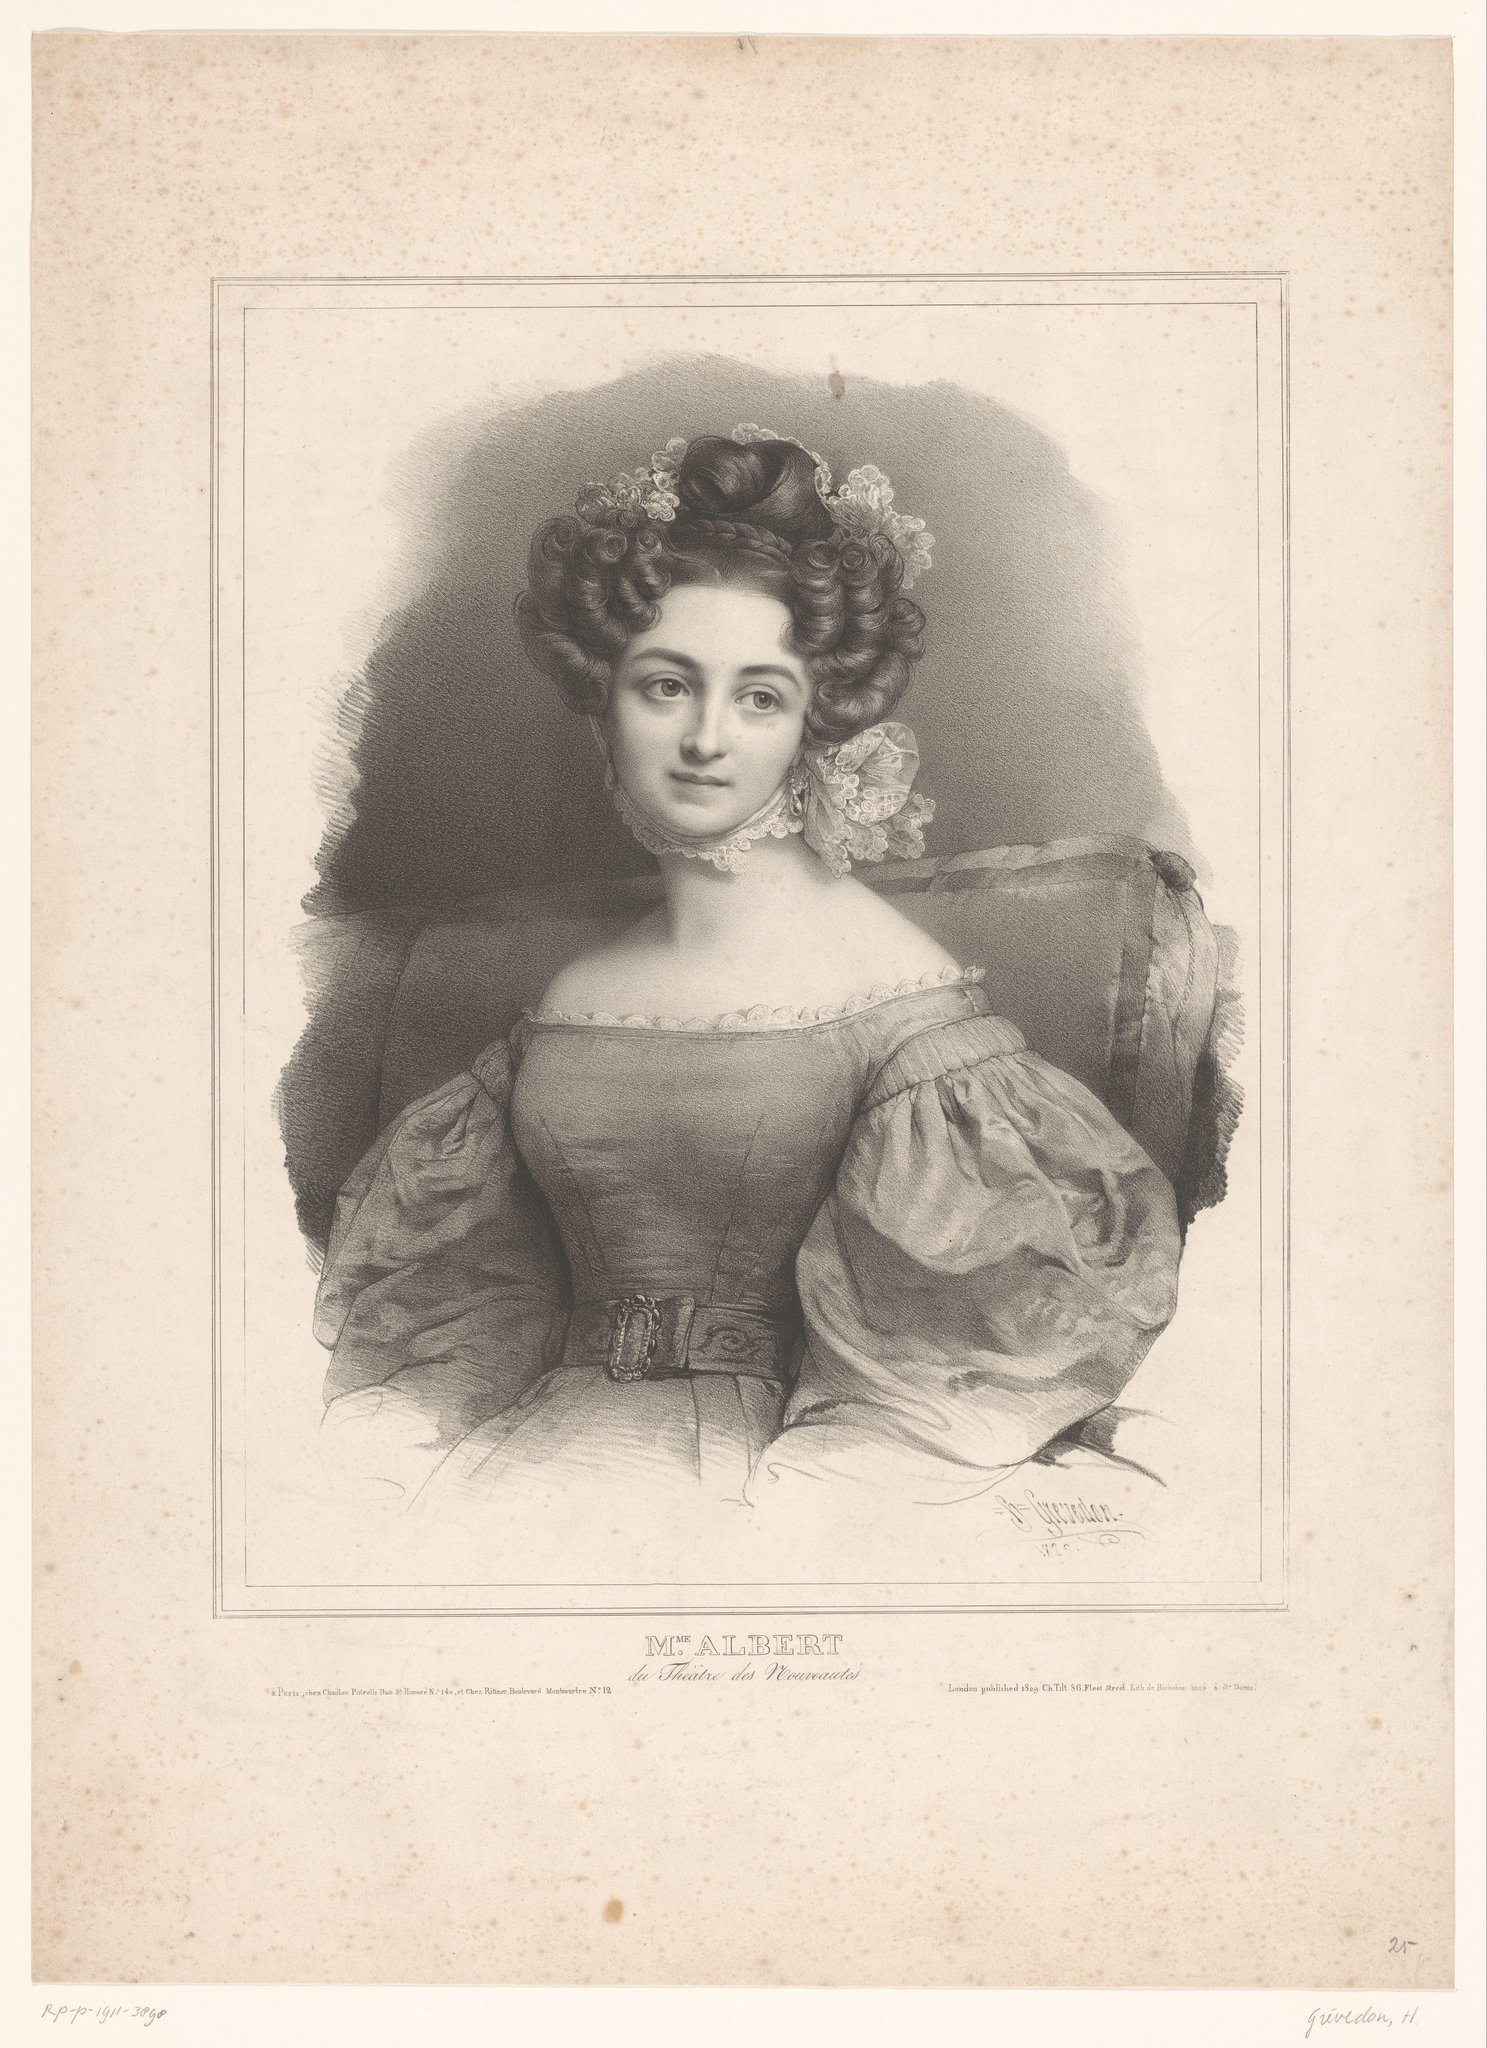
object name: print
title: Actrices van het Theater en de Opera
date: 1829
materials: paper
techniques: lithograph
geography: saint-denis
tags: historical persons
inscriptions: collector's mark: Lugt 2228a